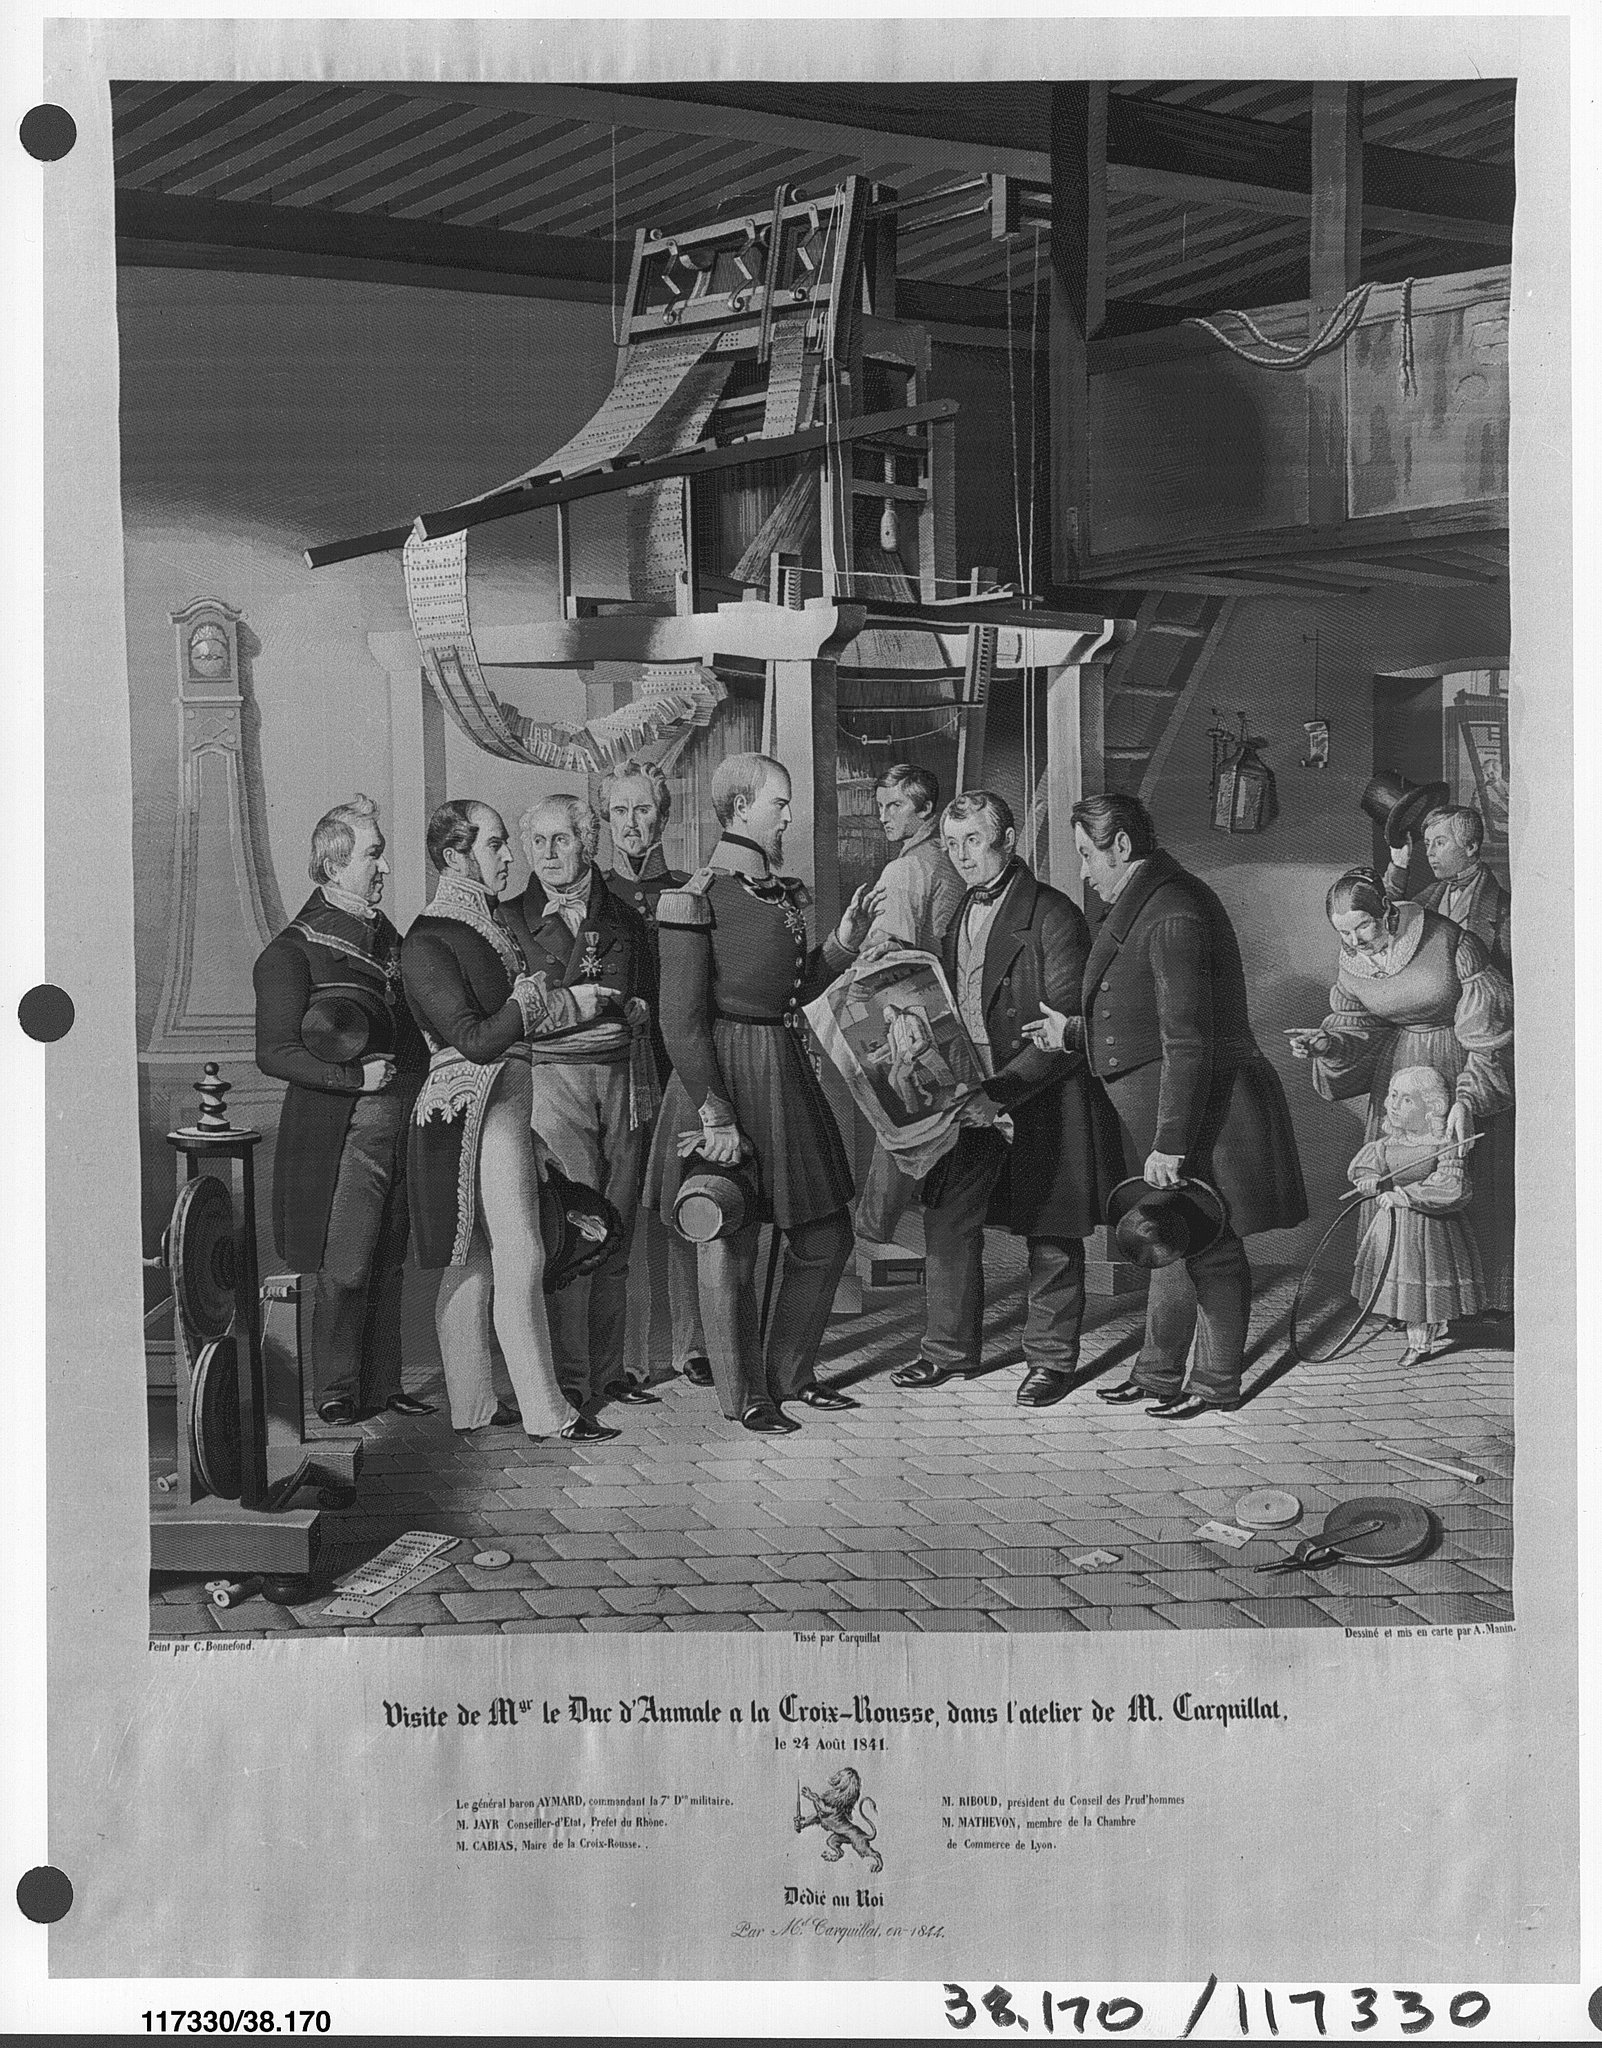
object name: picture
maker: claude bonnefond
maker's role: designer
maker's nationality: french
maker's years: 1796-1860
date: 1844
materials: silk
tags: girls,men,women,insignia